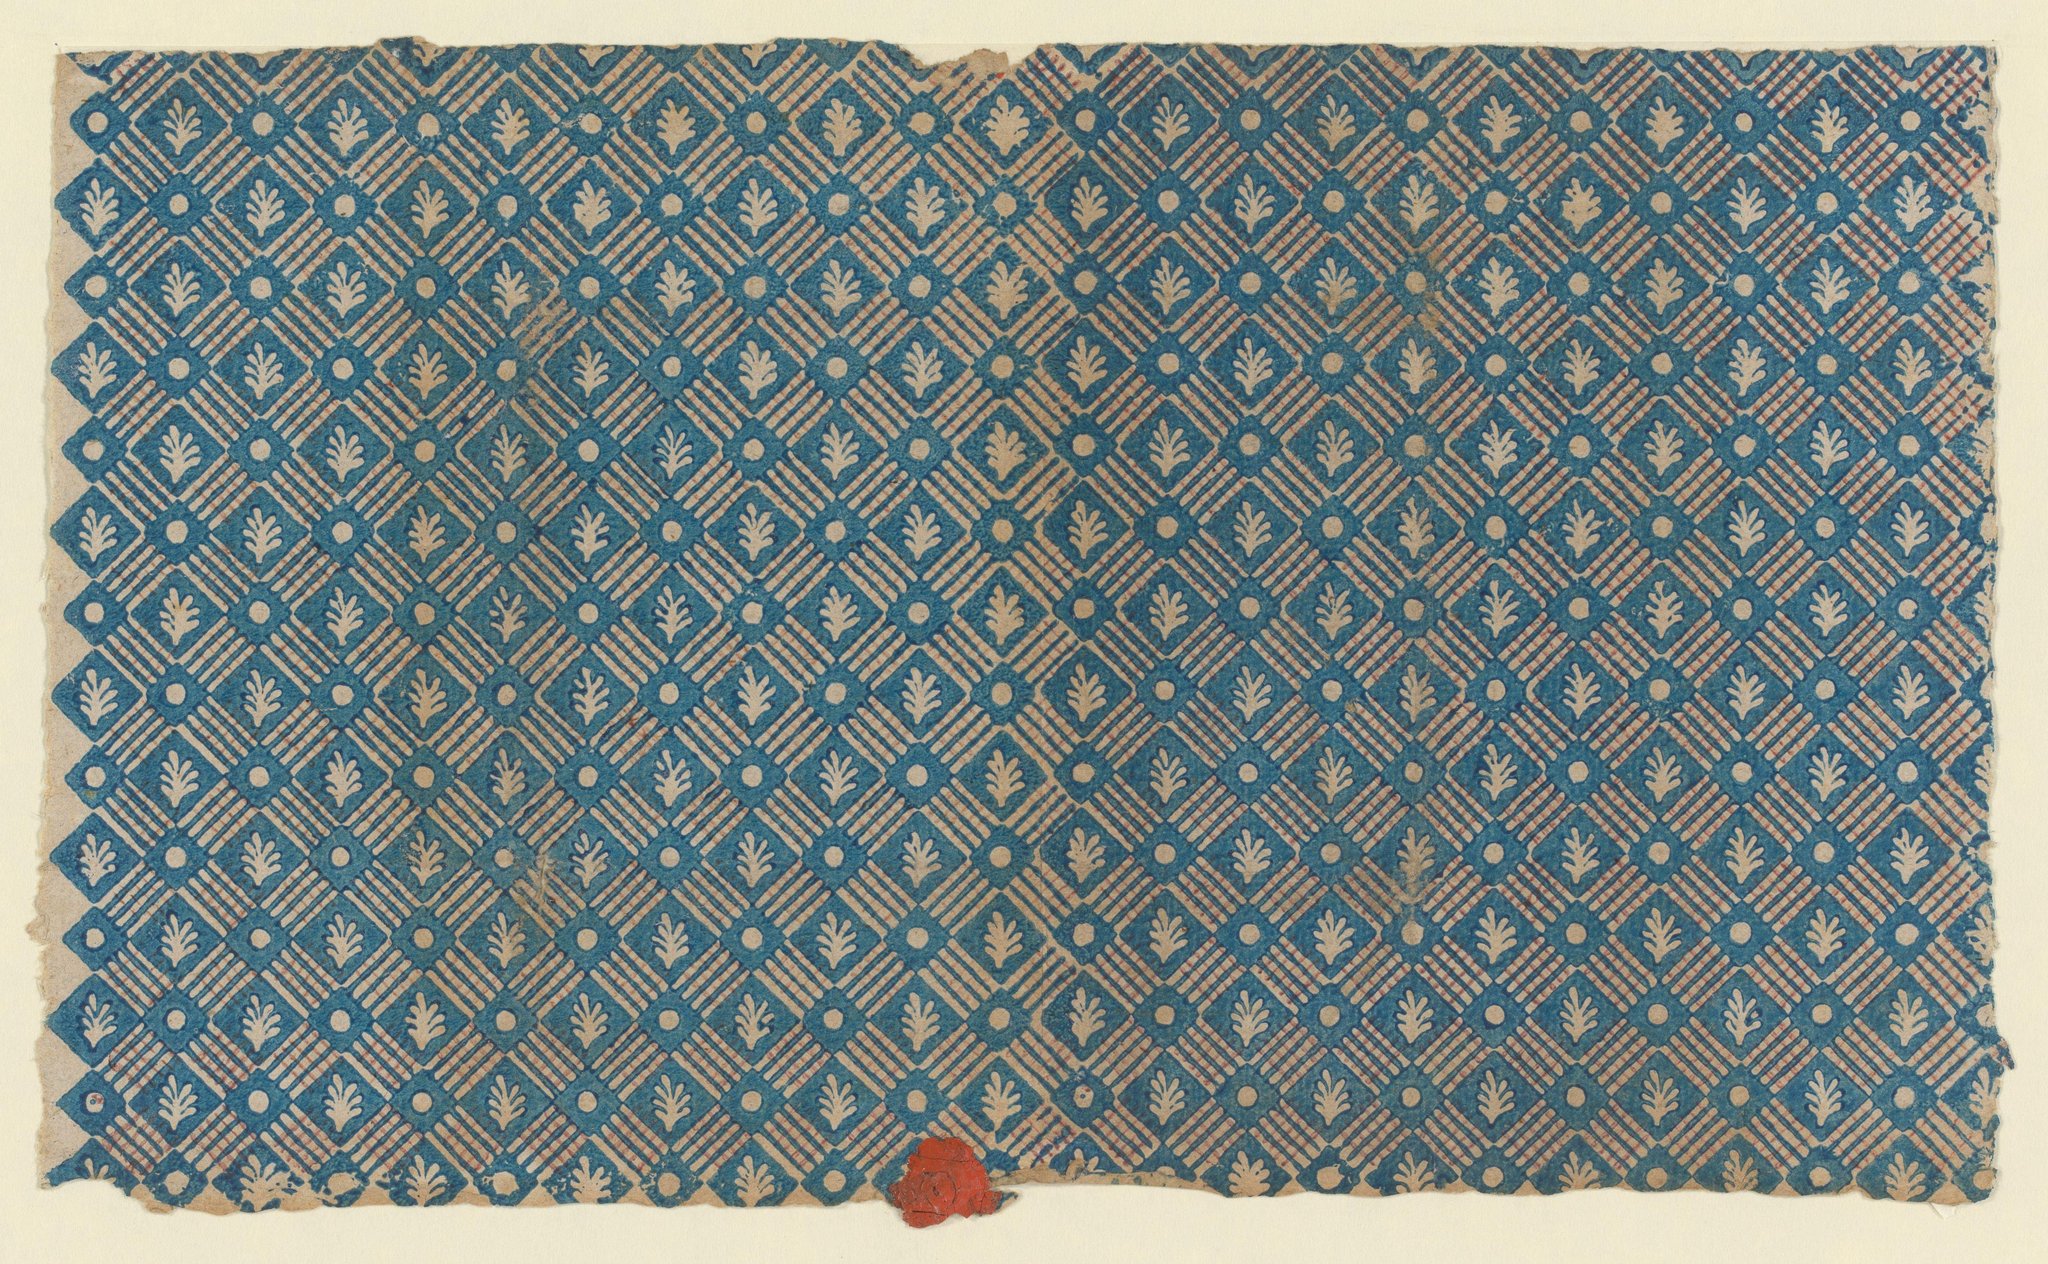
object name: printed paper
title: Blad met ruitenpatroon met uitgespaard takje en overhoekse uitgespaarde stip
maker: Anonymous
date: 1750-1900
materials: paper, wax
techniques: printing block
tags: ornament ~ geometric motifs, ornament derived from plant forms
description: Blad met ruitenpatroon met uitgespaard takje als veldvulling en overhoekse uitgespaarde stippen. Onderaan een fragment van een zegel in rood lak. Gebruikt als omslag.